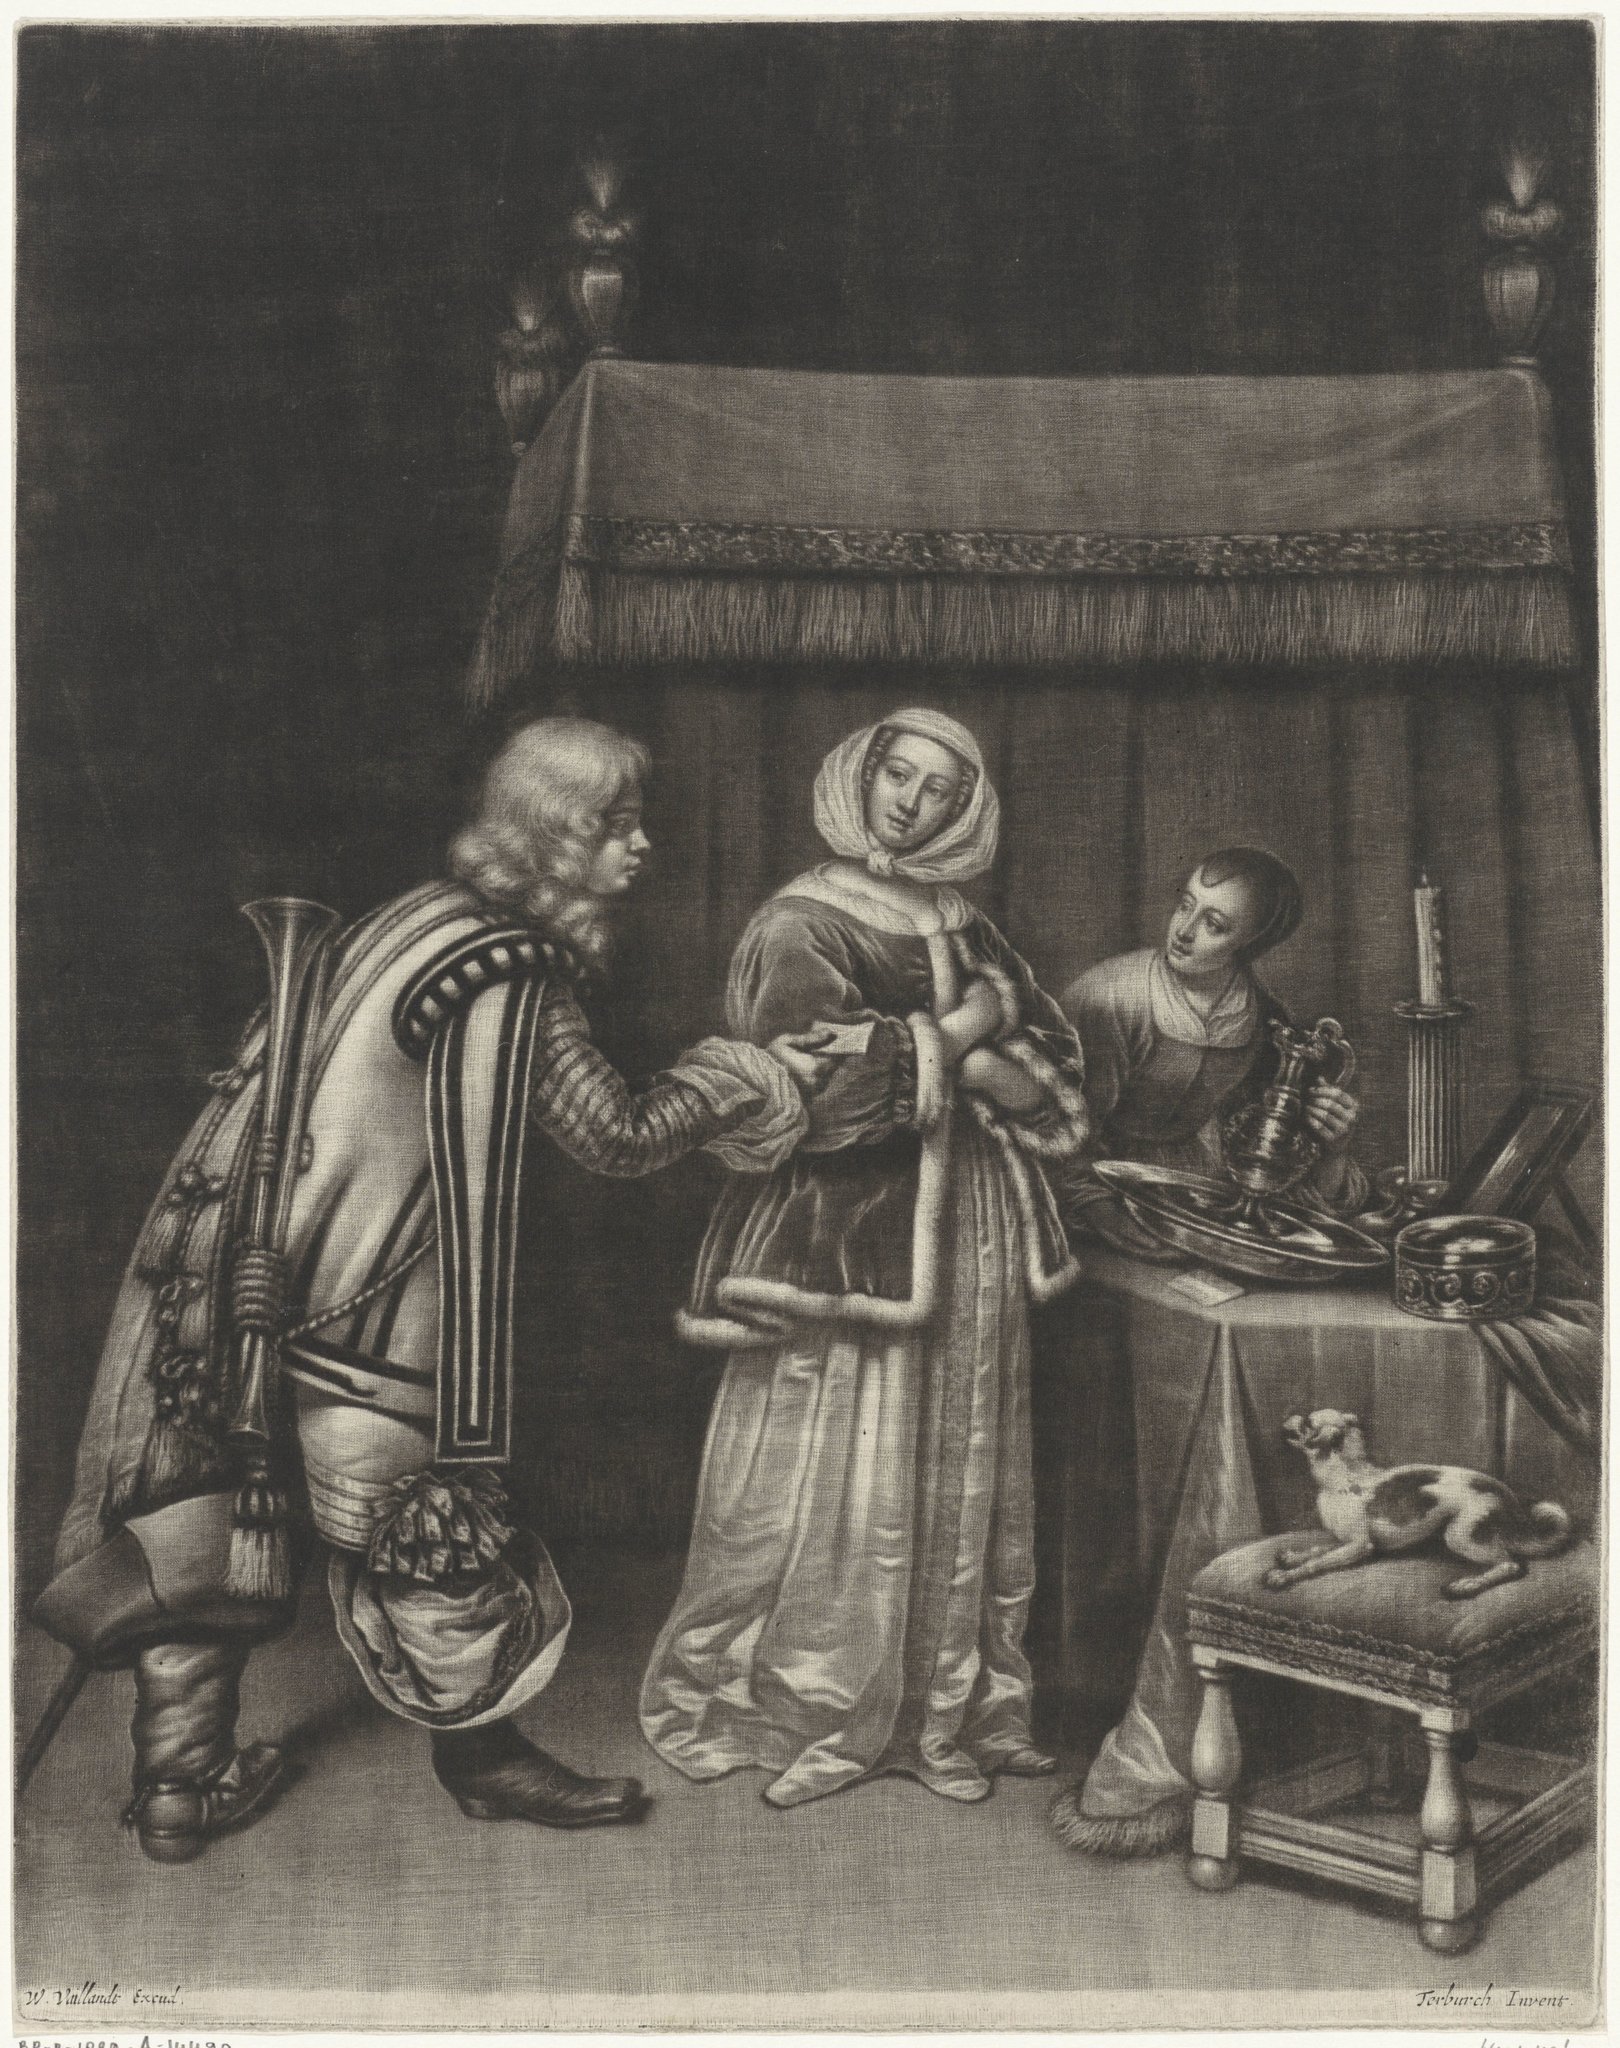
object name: print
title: Geweigerde brief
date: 1668-1677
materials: paper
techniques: mezzotint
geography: amsterdam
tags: letter, envelope, dog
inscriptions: collector's mark: Lugt 2228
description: Een boodschapper, met op zijn rug een bazuin, reikt een vrouw een brief aan. Zij lijkt de brief niet aan te willen nemen, ze heeft haar armen over elkaar geslagen.